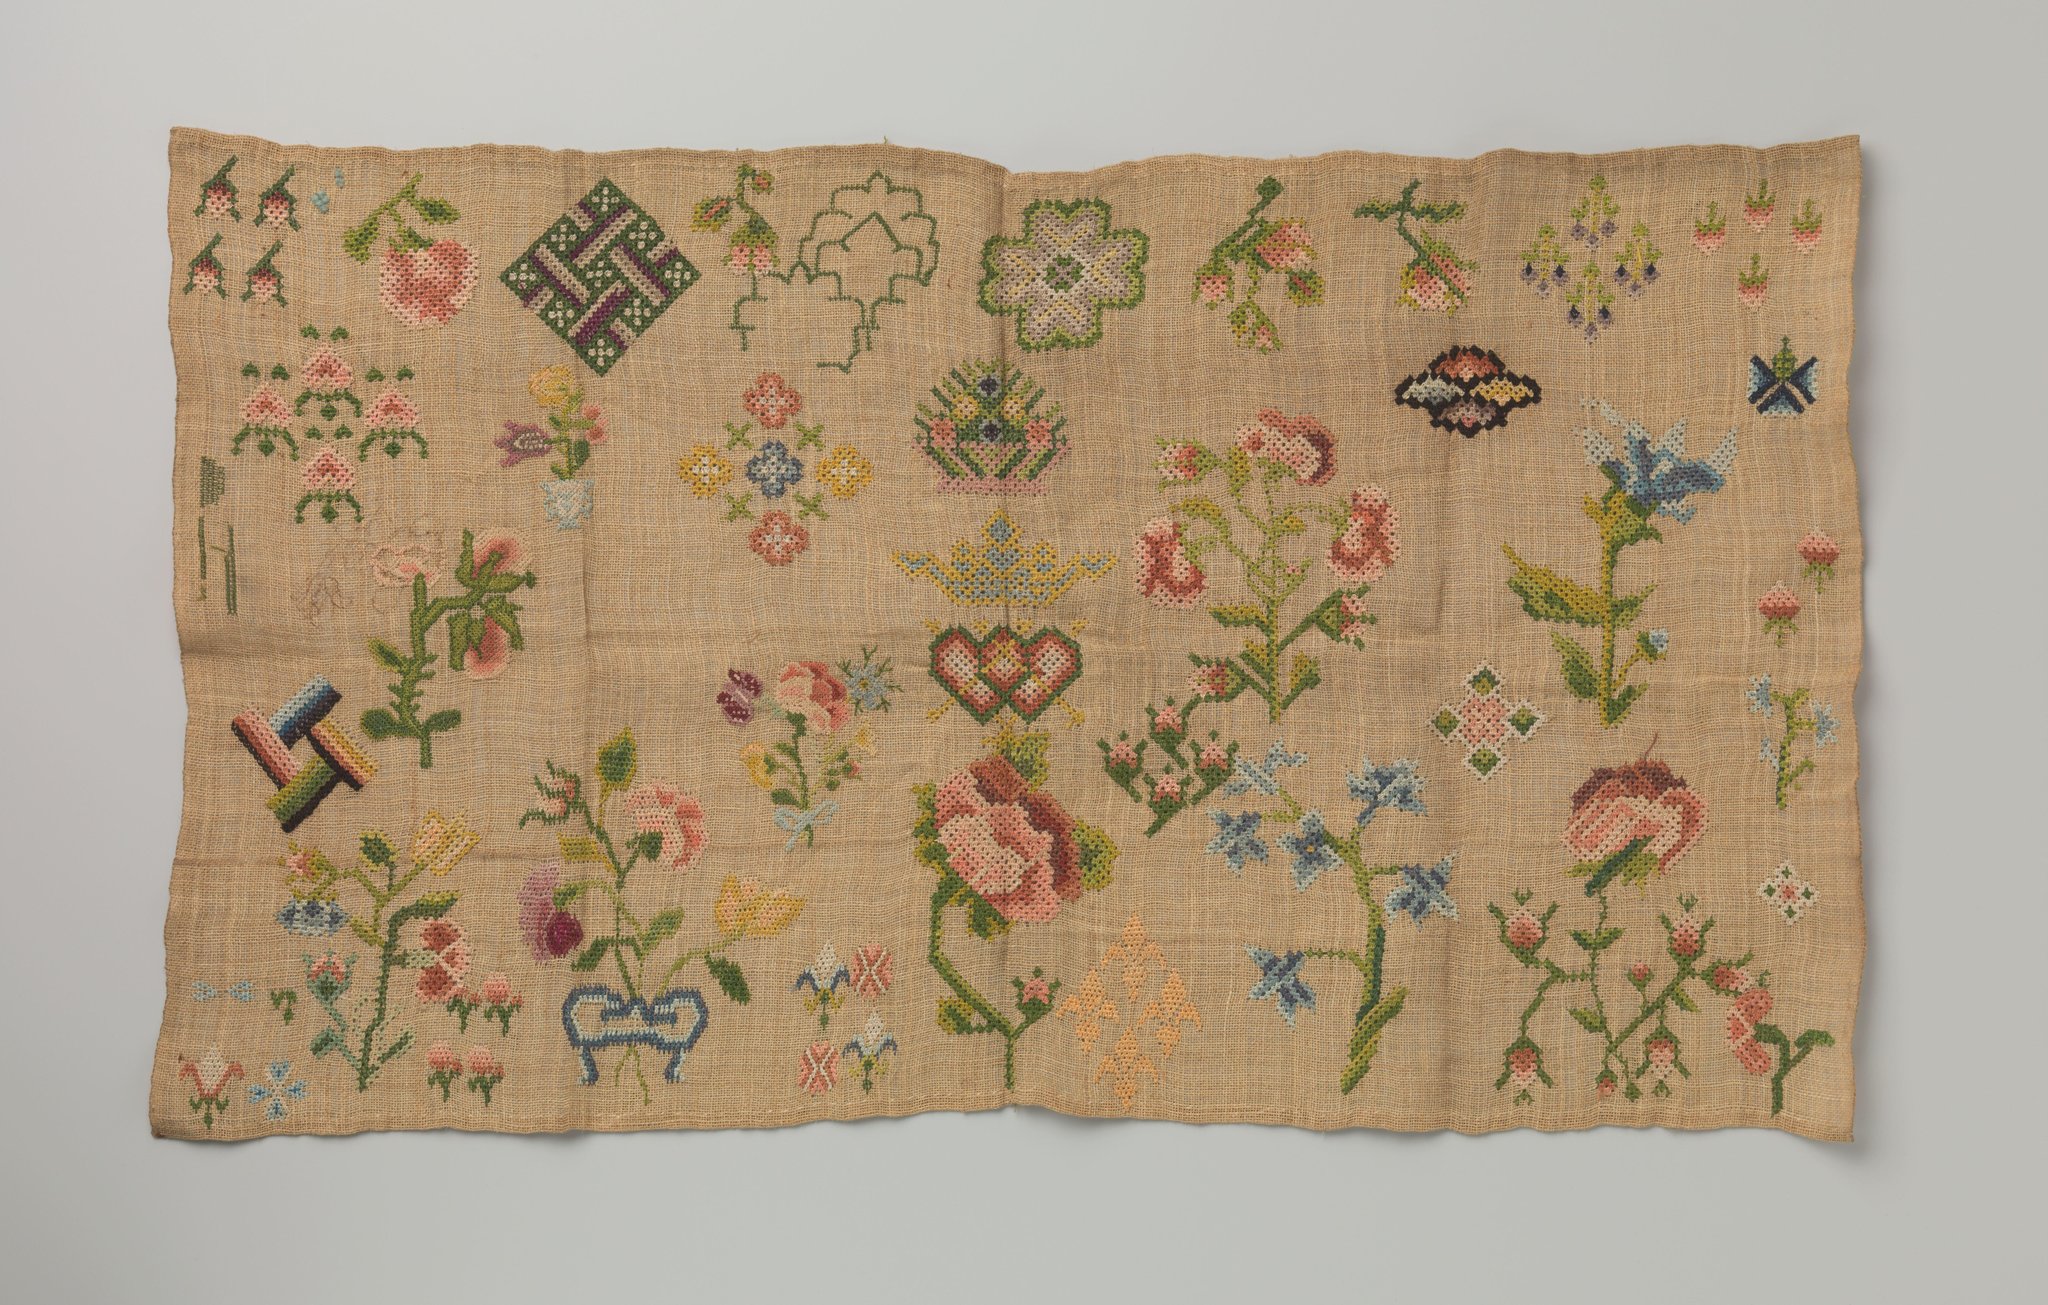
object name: borduurlap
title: Borduurlap van veelkleurige zijde op linnen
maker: Anonymous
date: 1780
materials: linen, silk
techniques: embroidered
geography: south holland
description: Het borduurwerk heeft rococo- of bundelsteek en petit point. De ondertekening is nog te zien.